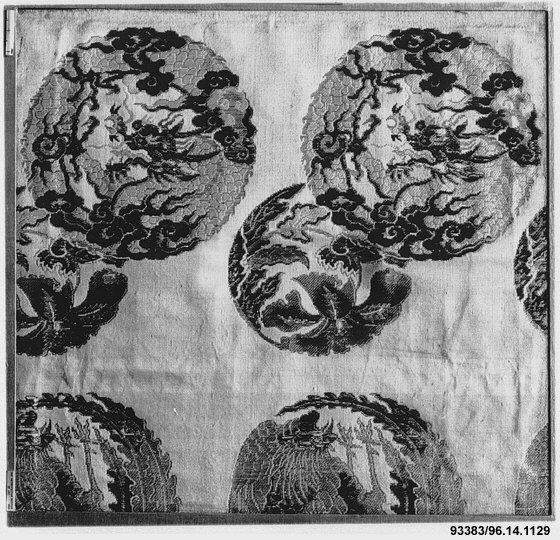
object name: piece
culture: japanese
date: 1701-1900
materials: silk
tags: dragons